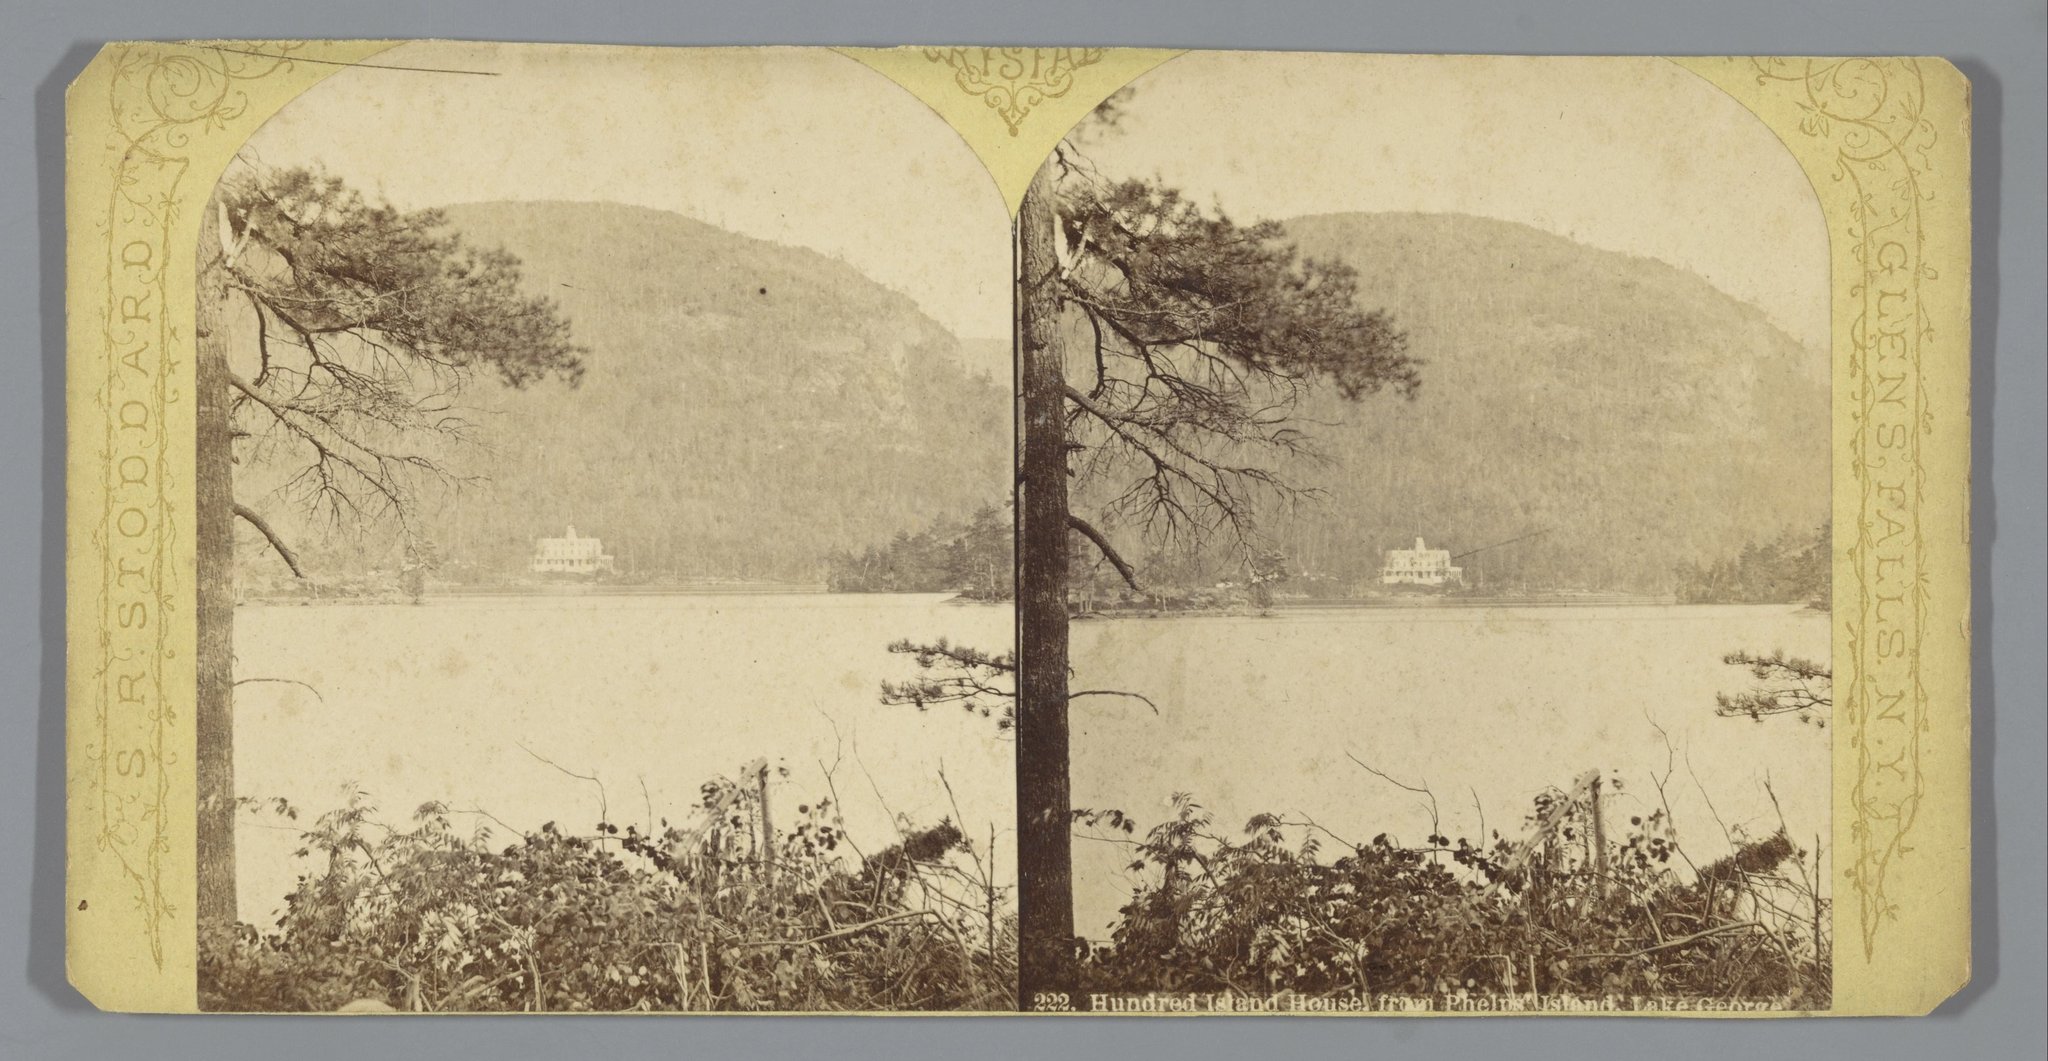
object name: stereograph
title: Hundred Island House, from Phelps Island, Lake George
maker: seneca ray stoddard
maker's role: fotograaf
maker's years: 1843-1917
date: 1870-1890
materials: cardboard, paper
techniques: albumen print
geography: phelps island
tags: lake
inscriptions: number: ‘222.’, : ‘Crystal/ Glens Falls, N.Y.’, retailer's mark: ‘Gebr. Douwes/ Ateliers/ Warmoesstraat 73./ Amsterdam’